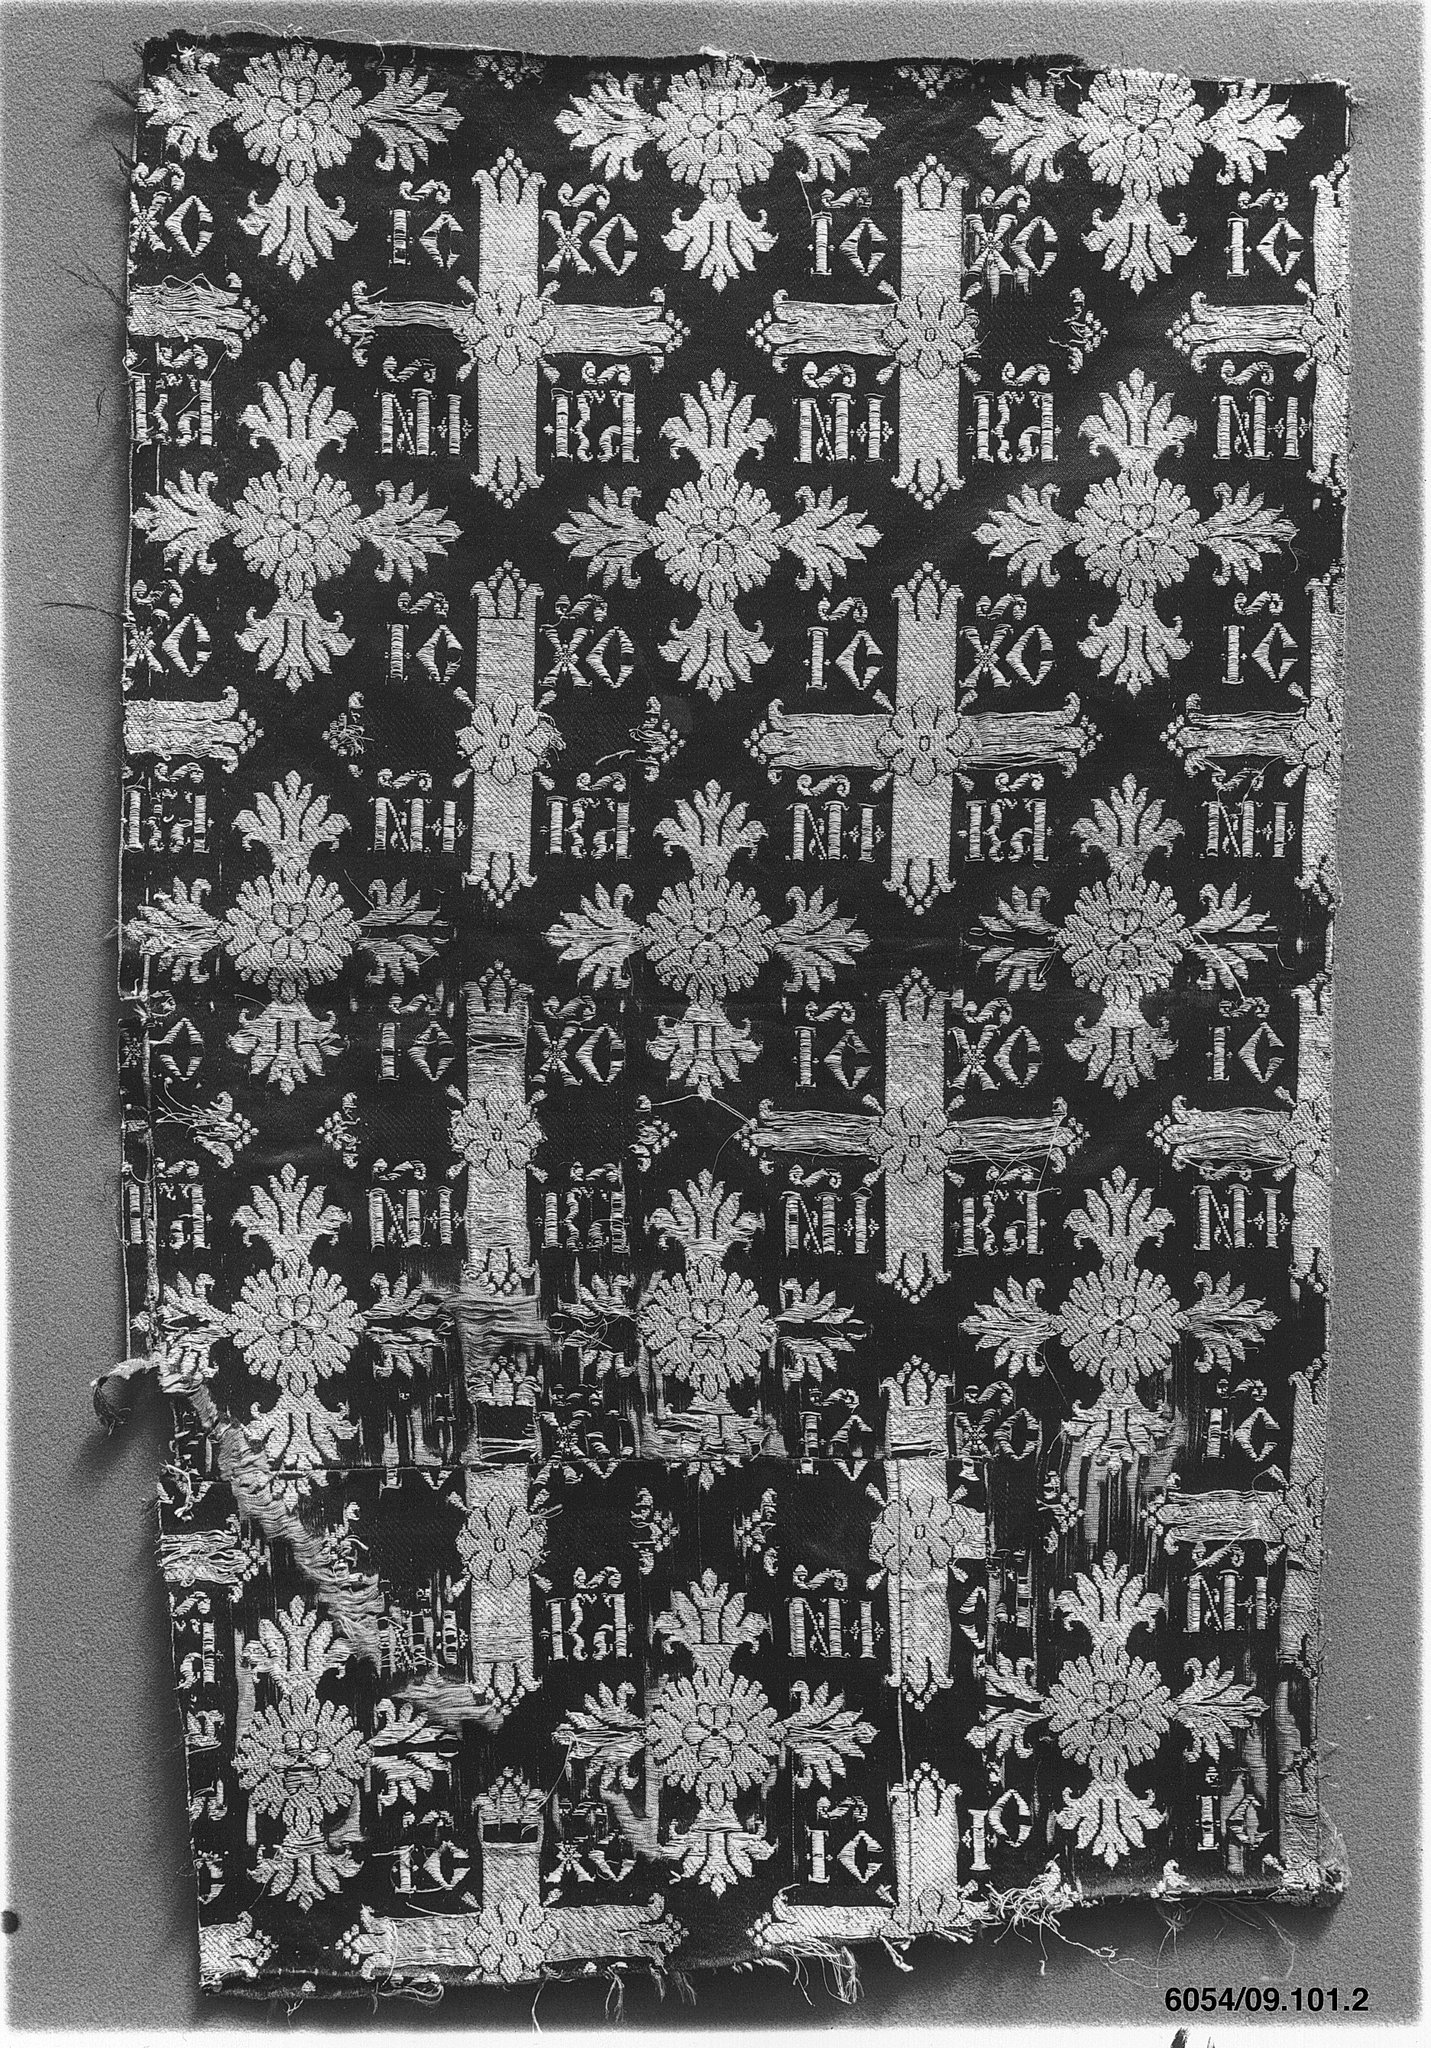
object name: piece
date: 1601-1700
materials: metal thread, textile